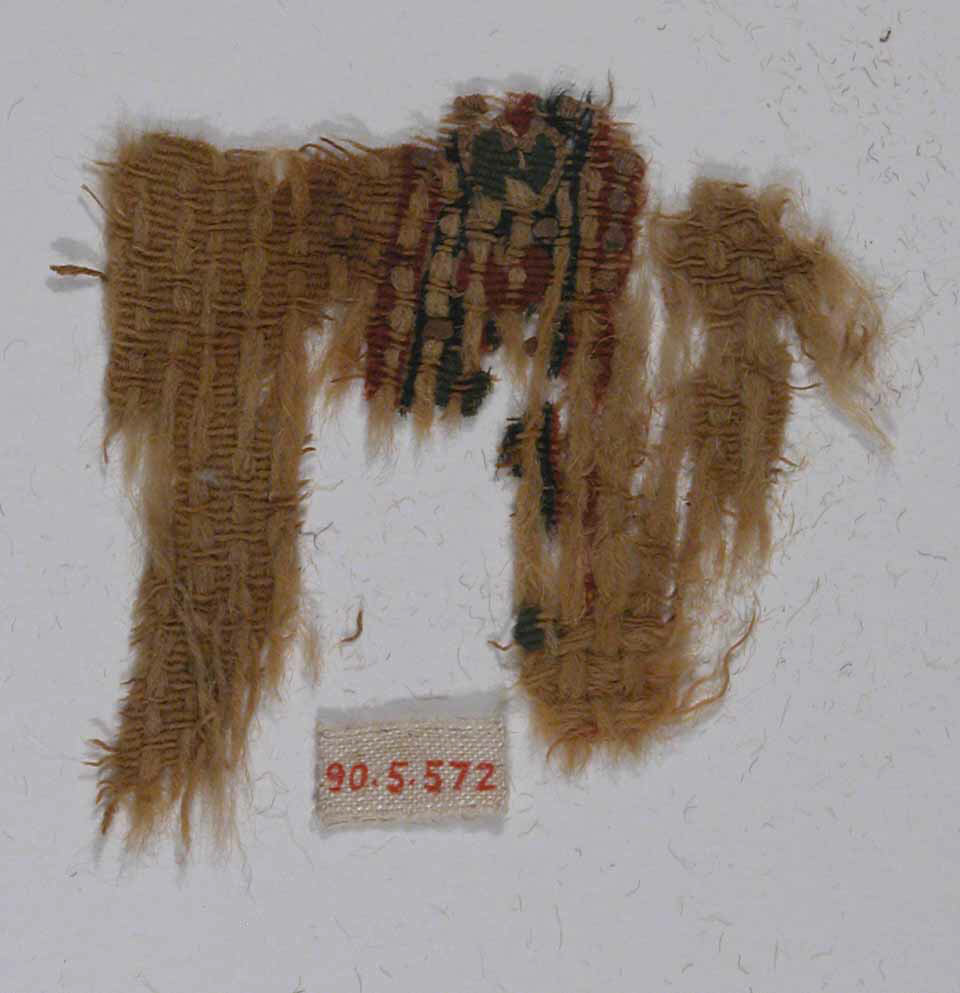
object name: textile fragment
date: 401-600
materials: linen, wool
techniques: weave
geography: egypt